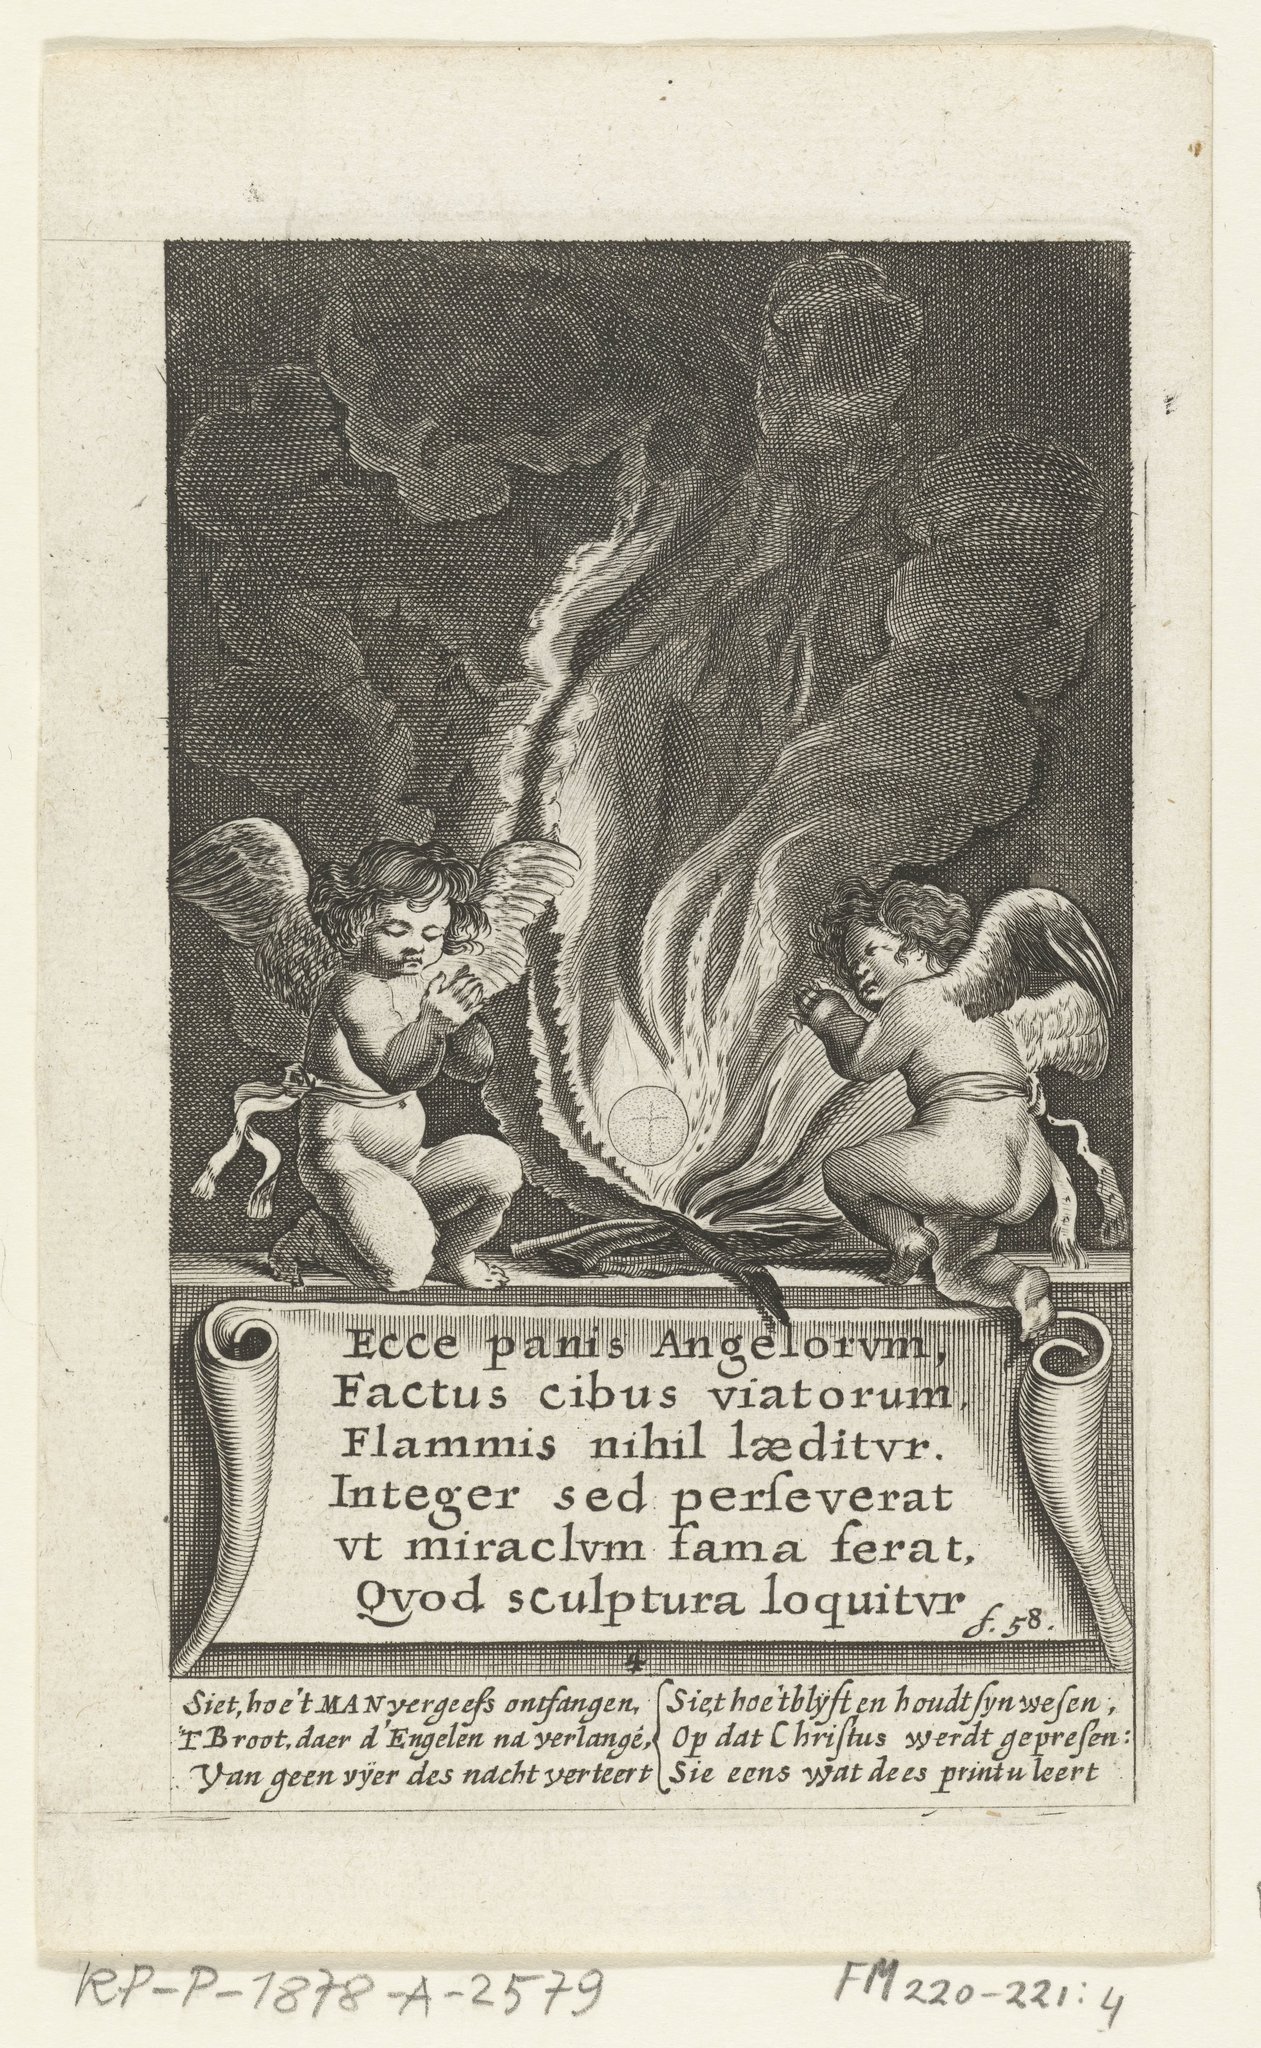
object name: history print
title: De hostie in het vuur, aan weerszijden engelen, 4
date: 1639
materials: paper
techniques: engraving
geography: southern netherlands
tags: amsterdam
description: Twee engelen knielen aan weerszijden van het vuur waarin de hostie ongeschonden zweeft. Hieronder een cartouche met een gegraveerd zesregelig vers in het Latijn. Prent nr. 4 uit de serie van 16 voorstellingen van Het Mirakel van Amsterdam, naar de gebeurtenissen op 15 maart 1345. Onder de voorstelling een zesregelig vers in het Nederlands.